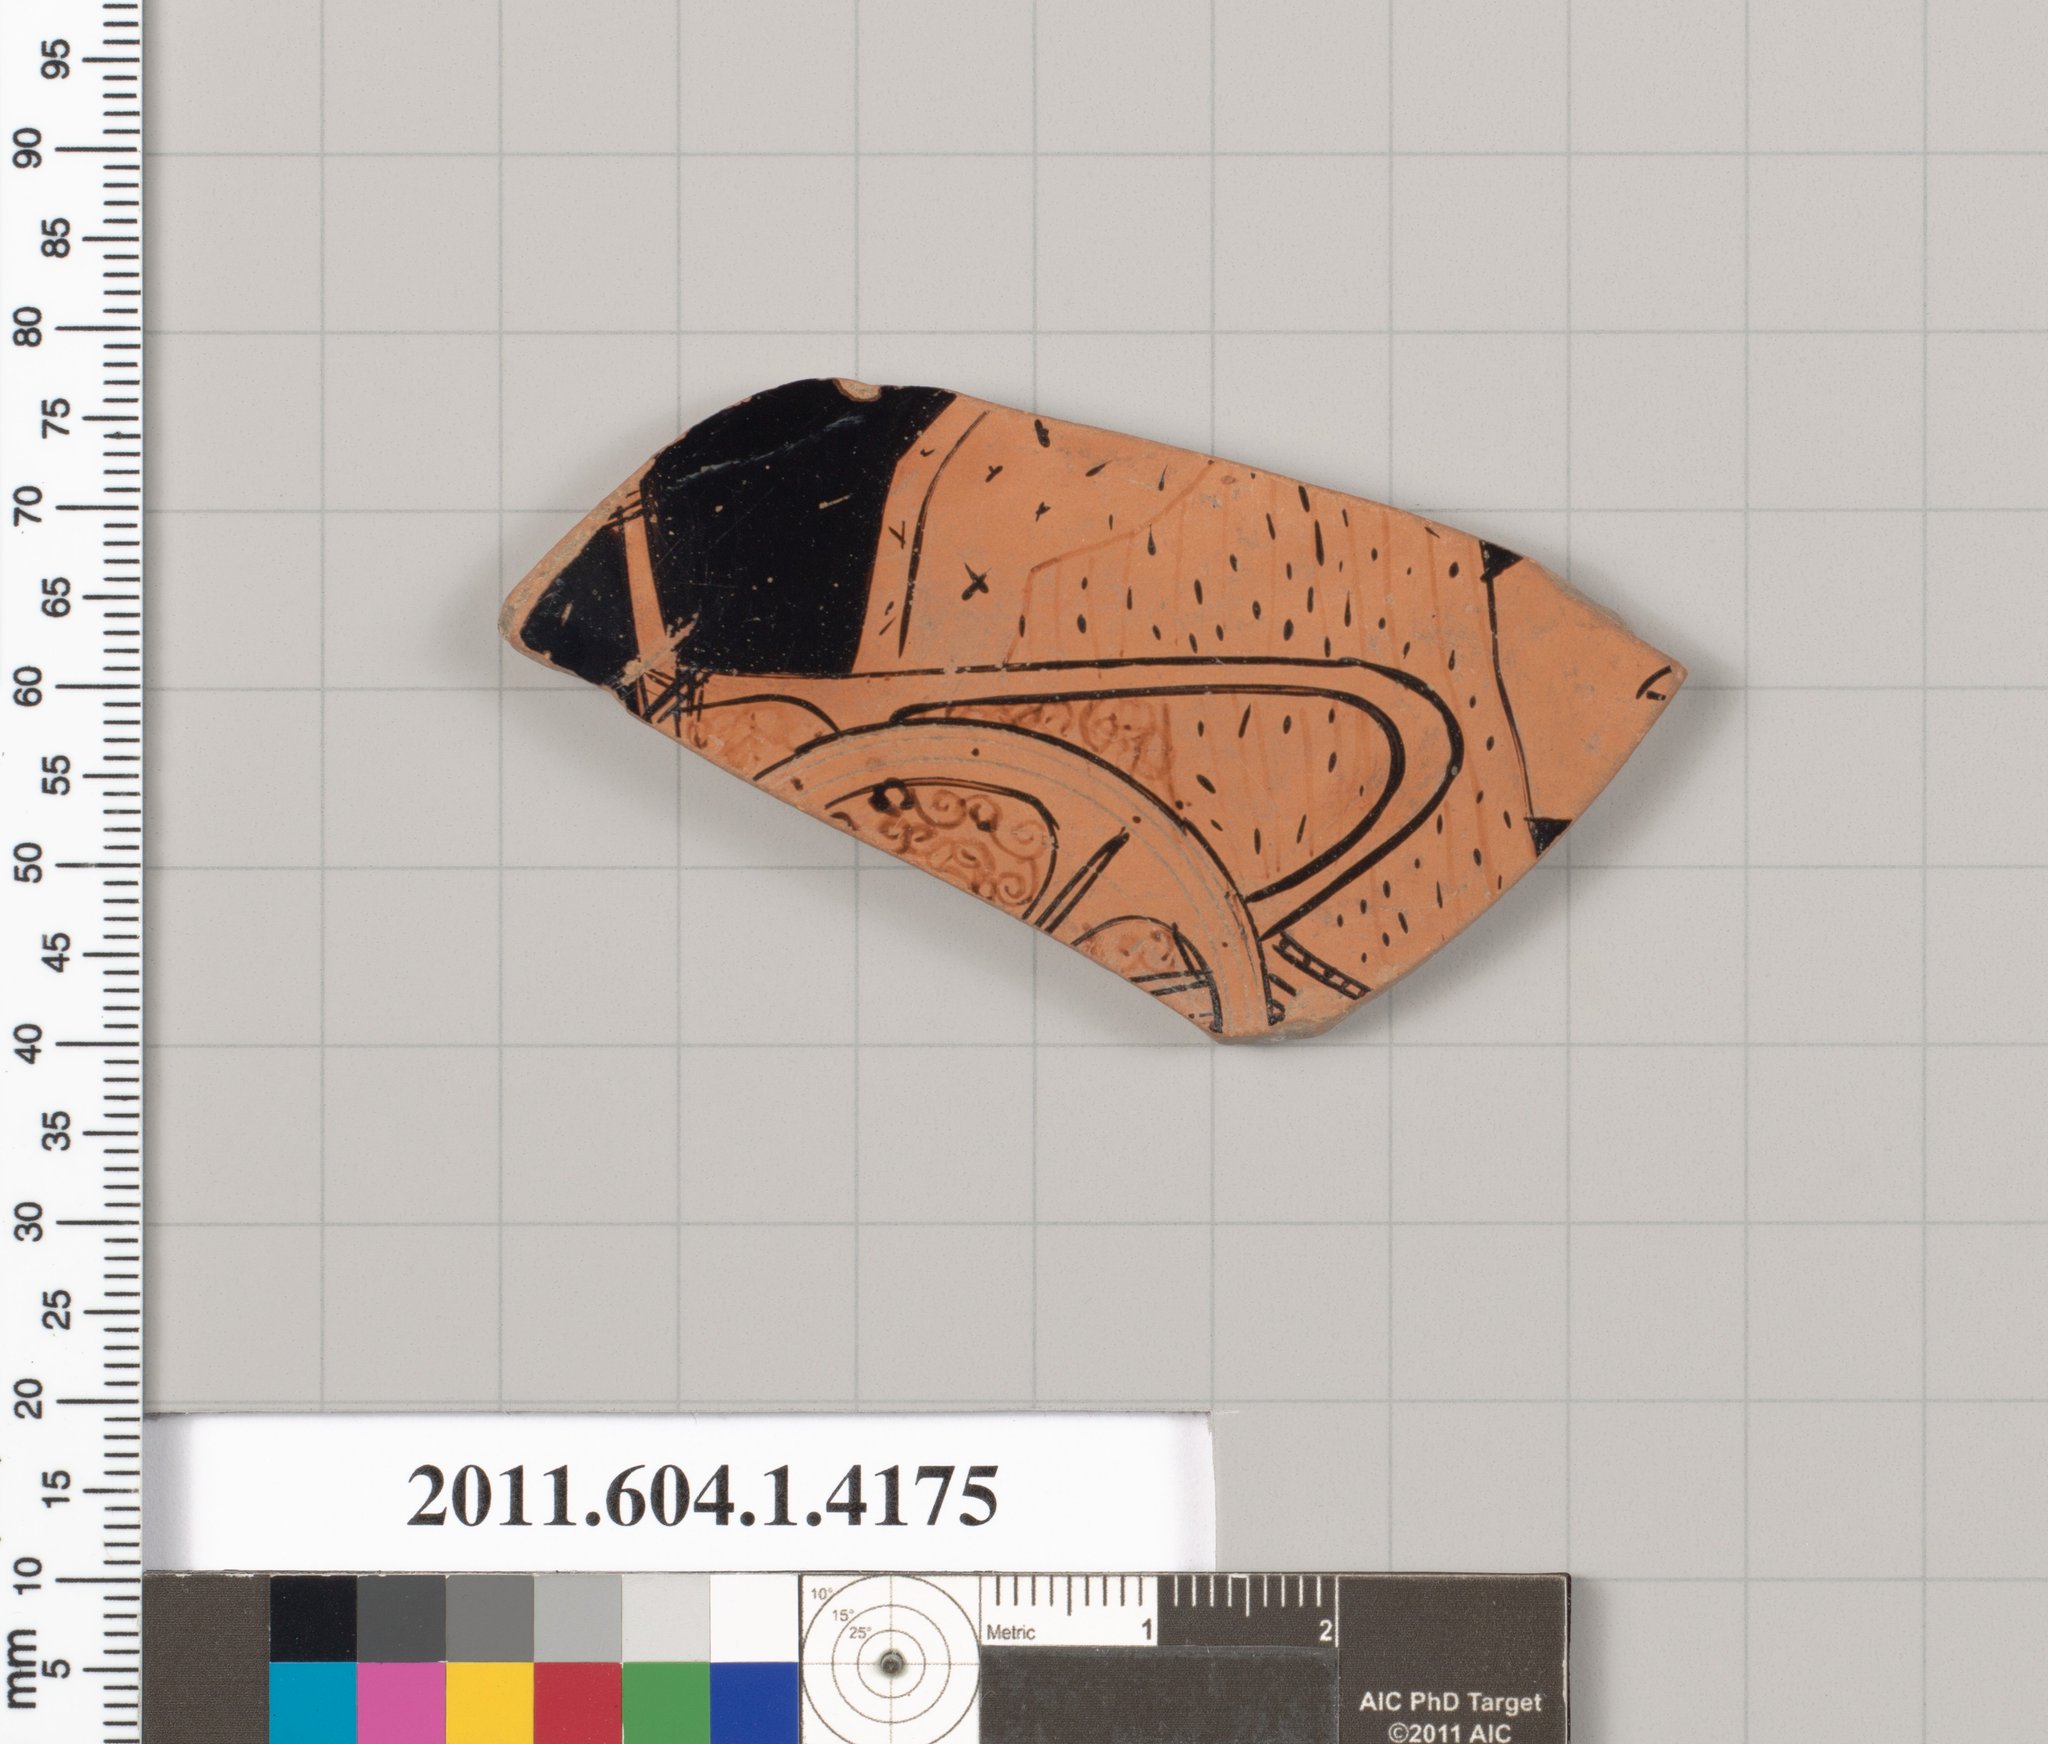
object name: kylix fragment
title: Terracotta fragment of a kylix (drinking cup)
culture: greek, attic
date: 500-480 BCE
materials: terracotta